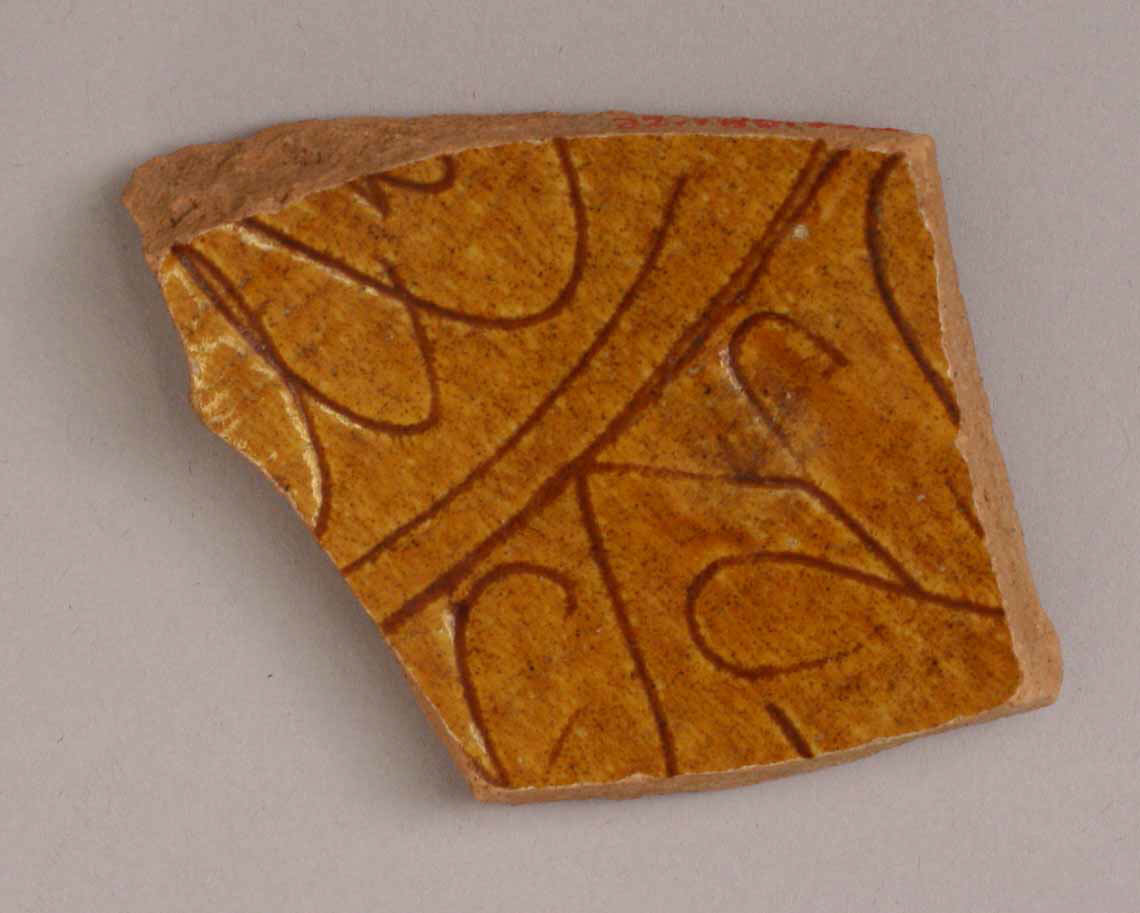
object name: fragment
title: Ceramic Fragment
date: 701-900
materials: earthenware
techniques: glazing, incising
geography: iraq